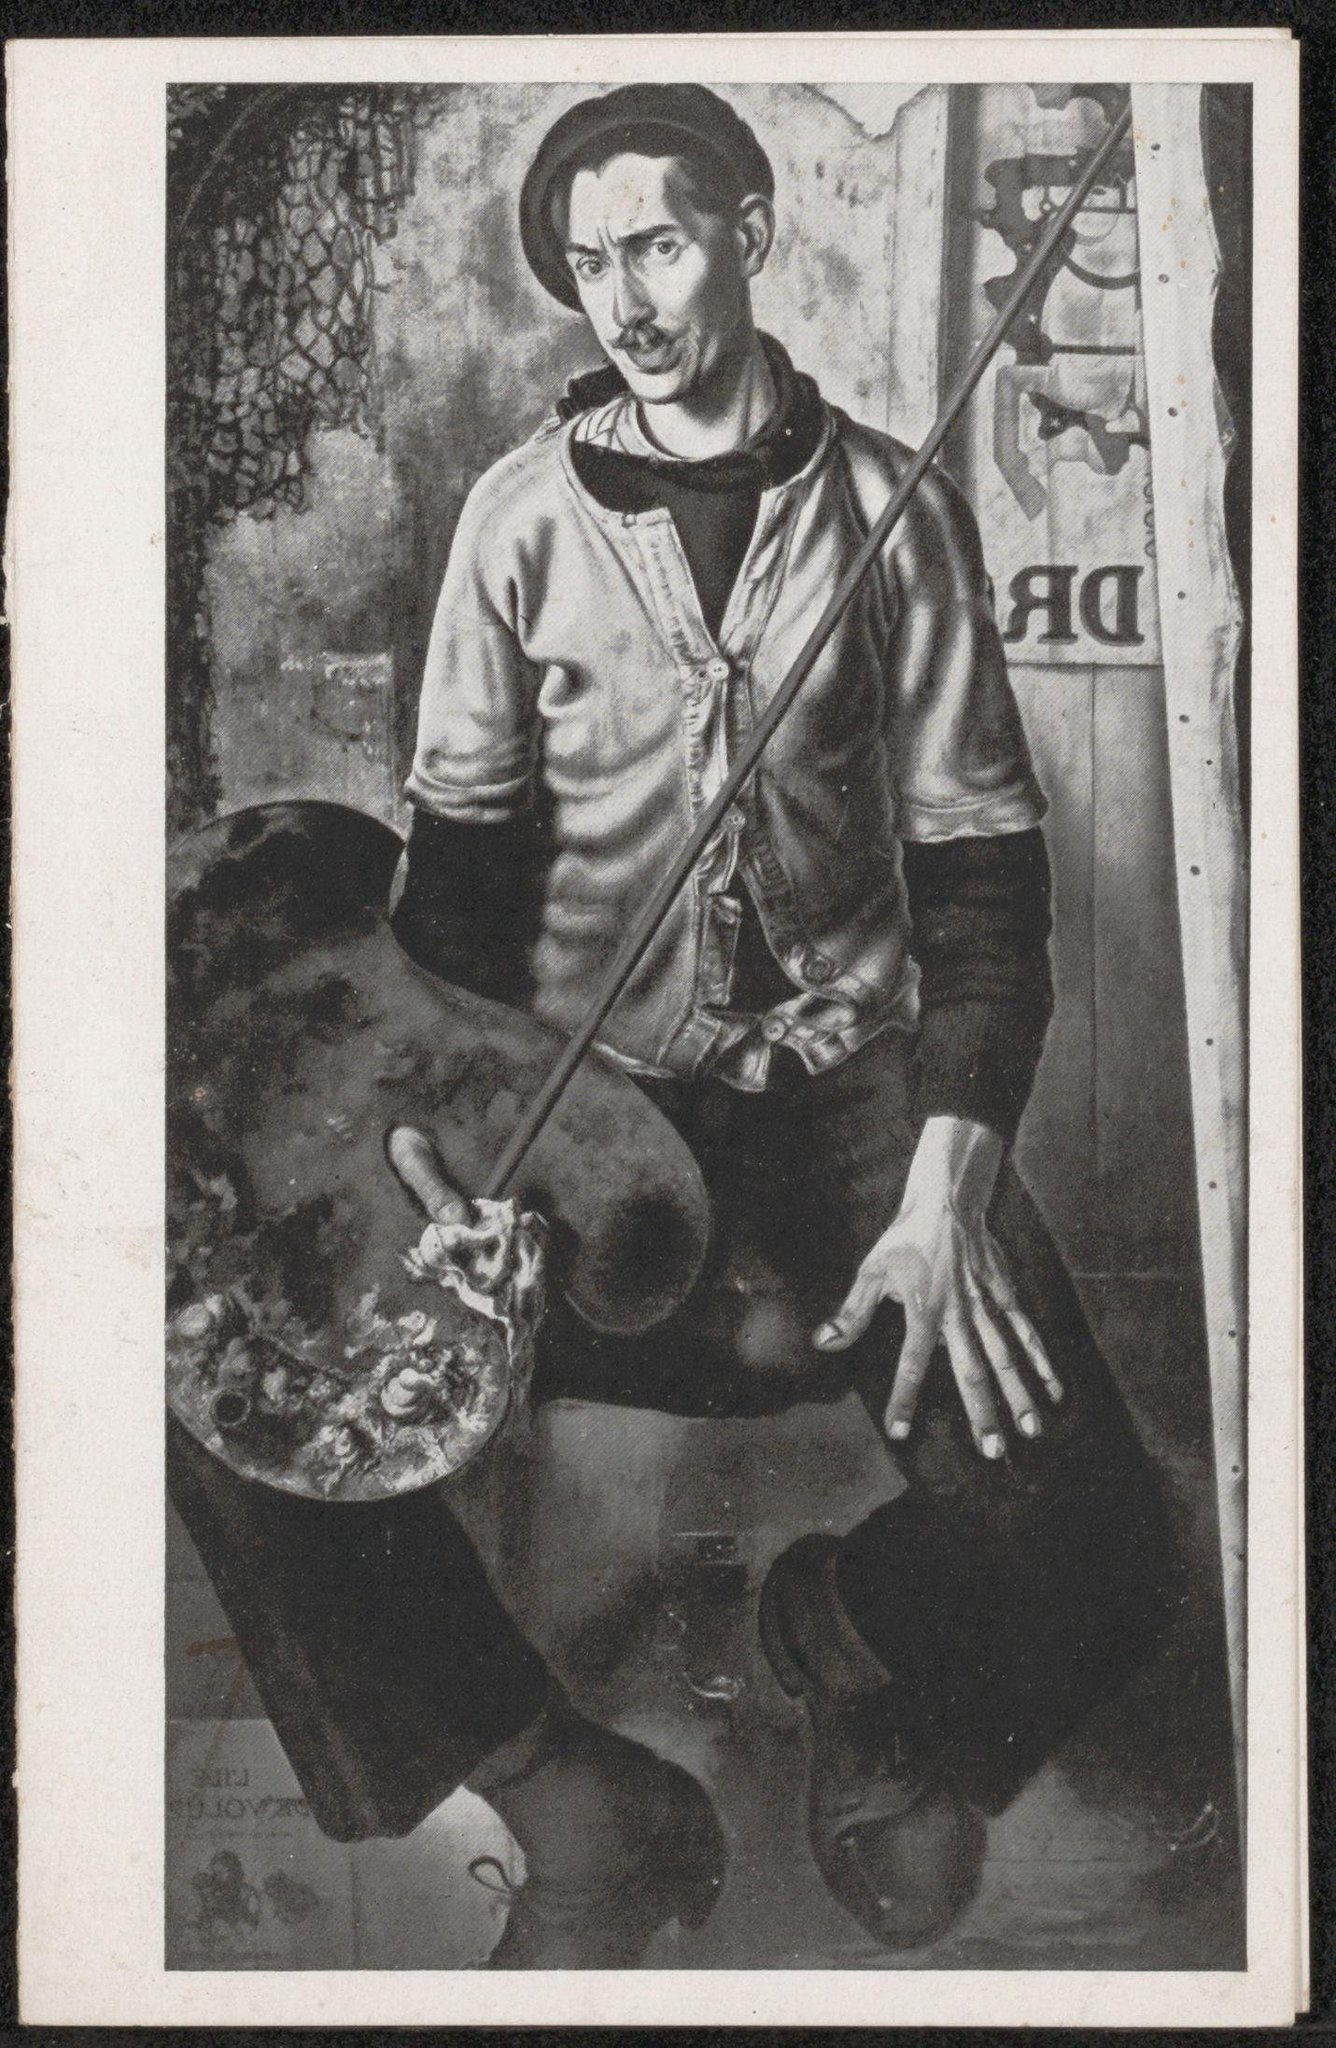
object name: invitation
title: Uitnodigingen voor de opening van een tentoonstelling van schilderijen van Dick Ket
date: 1904-1941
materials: cardboard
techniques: printing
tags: draughtsman, dick ket, painting (including book-illumination, miniature-painting), exhibition ~ art, amsterdam